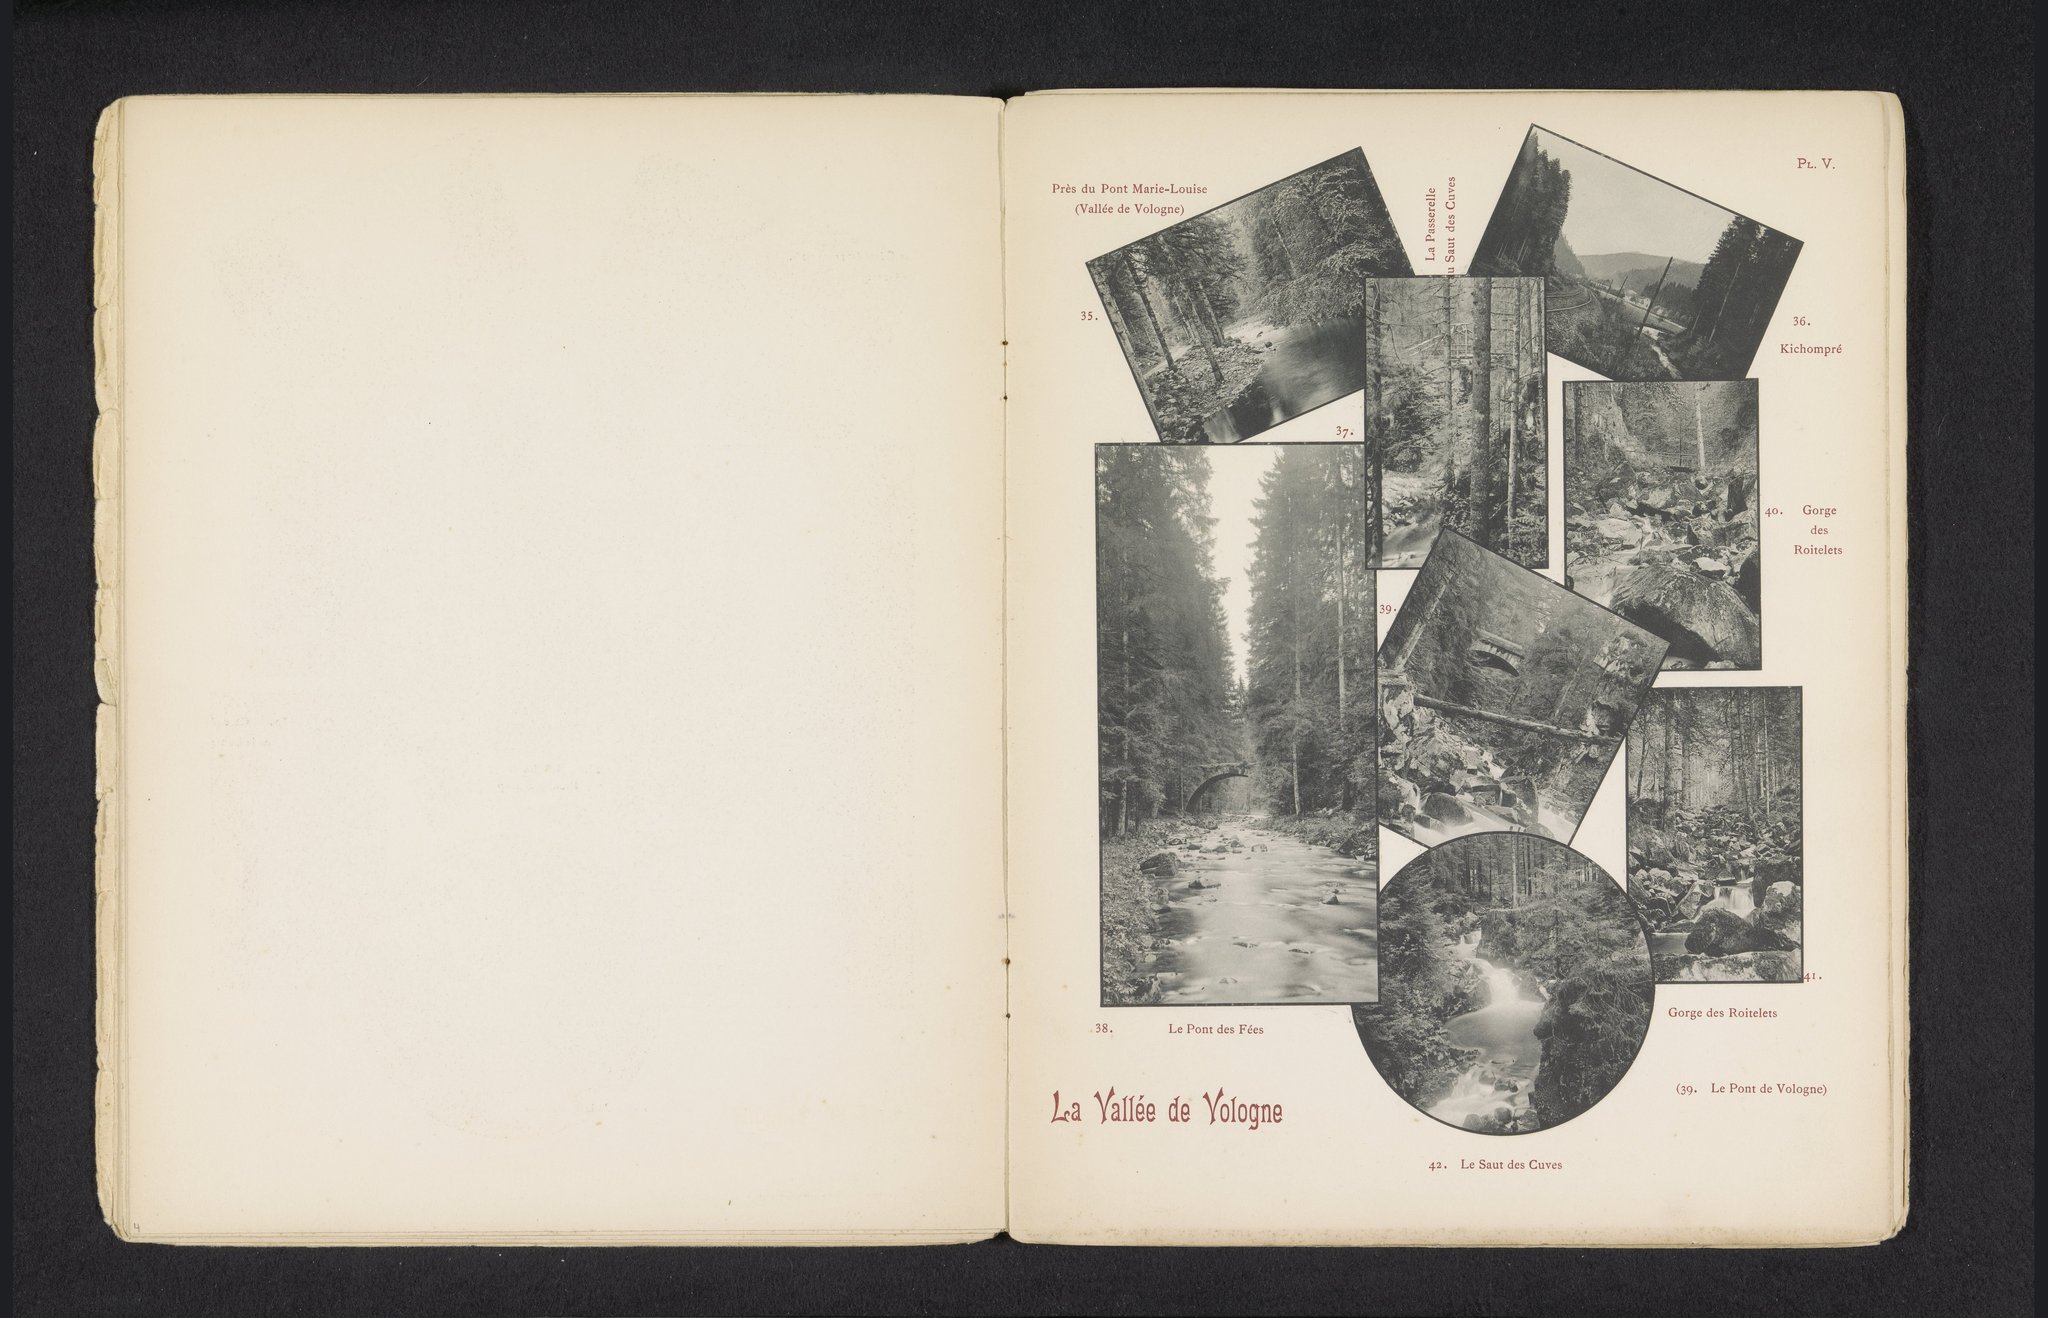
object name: page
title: Acht plekken rond de rivier de Vologne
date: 1888-1898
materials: paper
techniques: photograph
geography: vosges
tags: river, forest, wood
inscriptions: number: ‘Pl. V.’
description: Nummers 35 tot en met 42 zijn gezichten op de rivier en de bosrijke vallei.